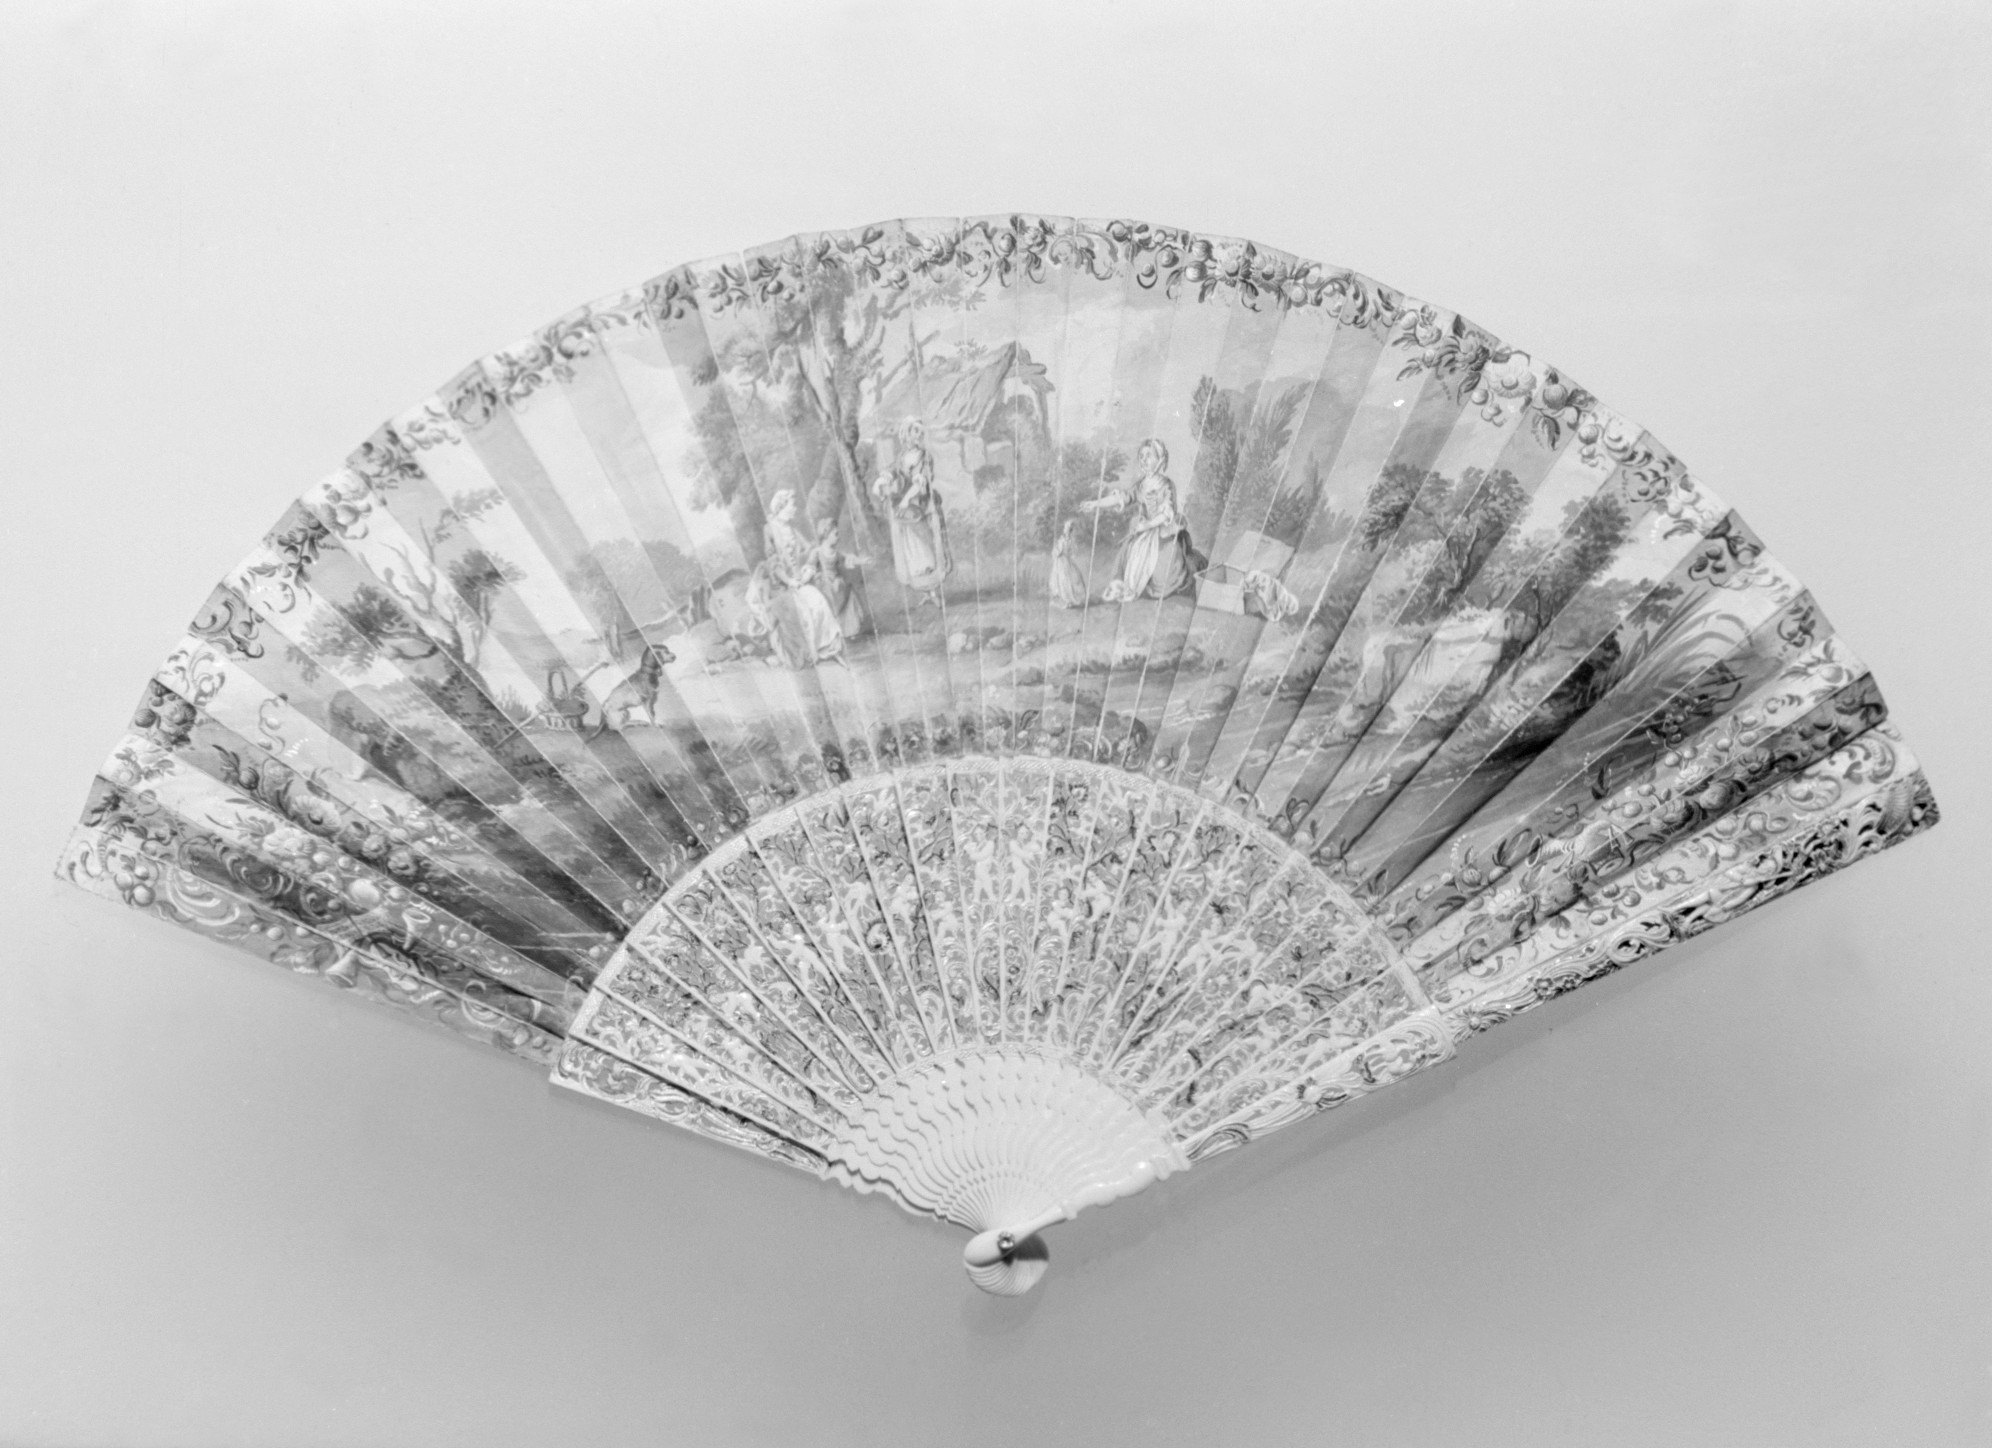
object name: fan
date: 1751-1775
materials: gold, ivory, paper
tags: children,women,dogs